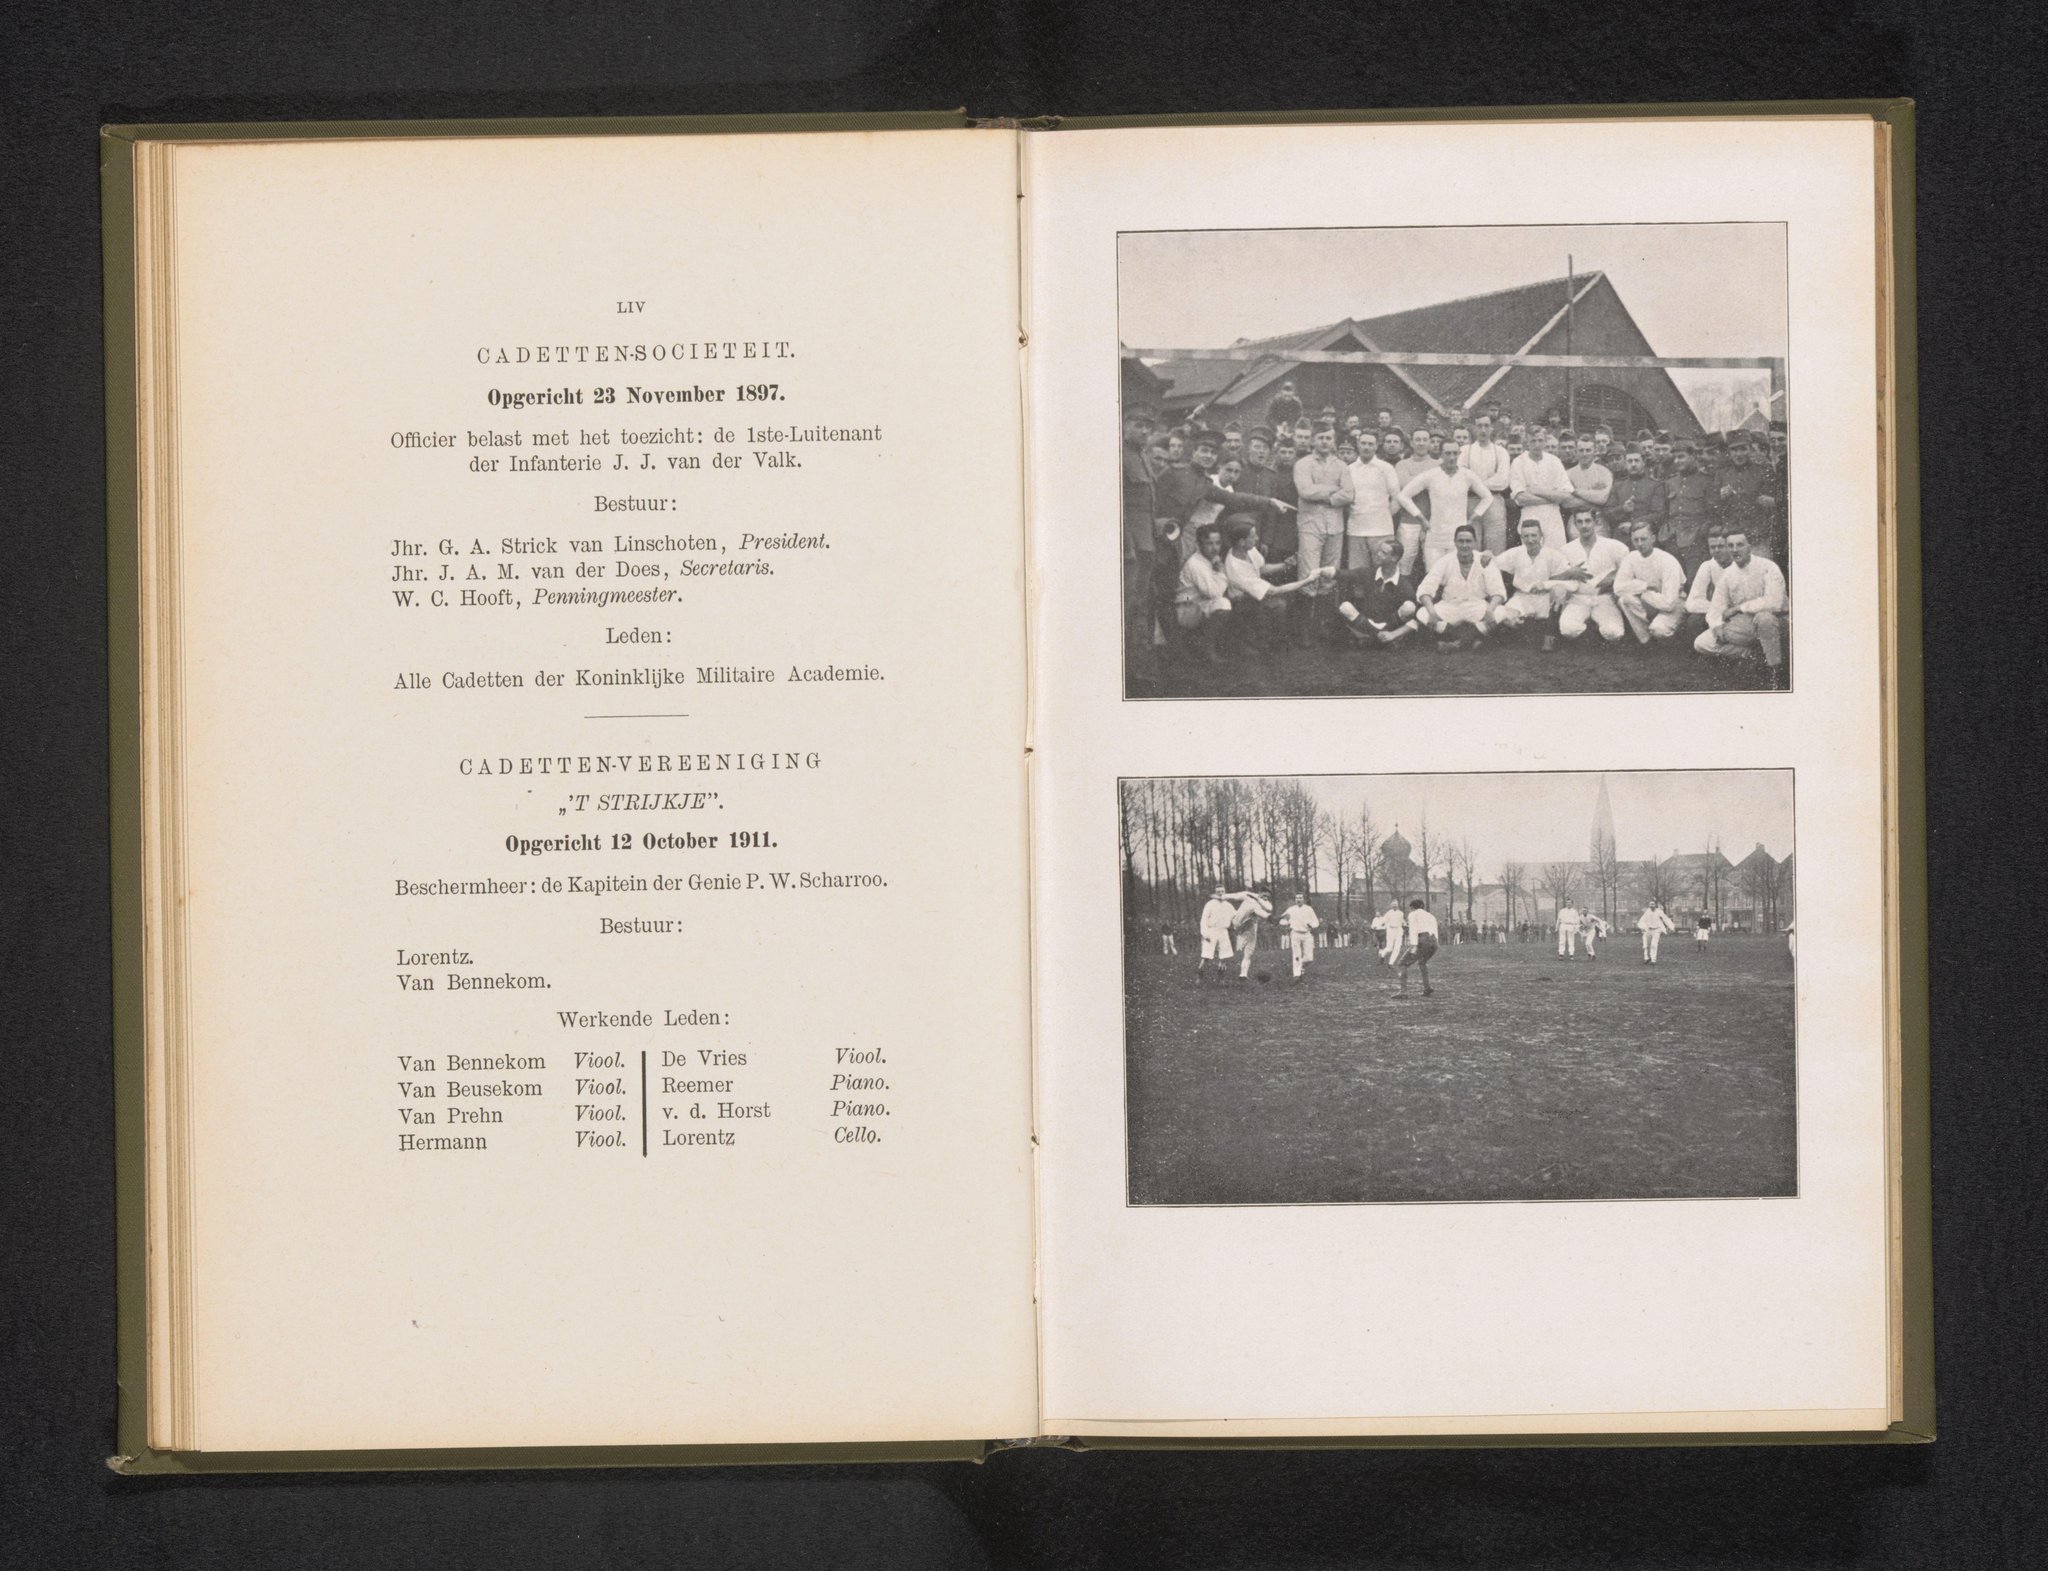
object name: page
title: Groepsportret van cadetten in sportkostuum van de Koninklijke Militaire Academie in Breda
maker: Anonymous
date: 1911-1916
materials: paper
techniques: autotype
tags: ball games (+ sportsman, player, etc.), anonymous historical persons portrayed in a group, in a group-portrait